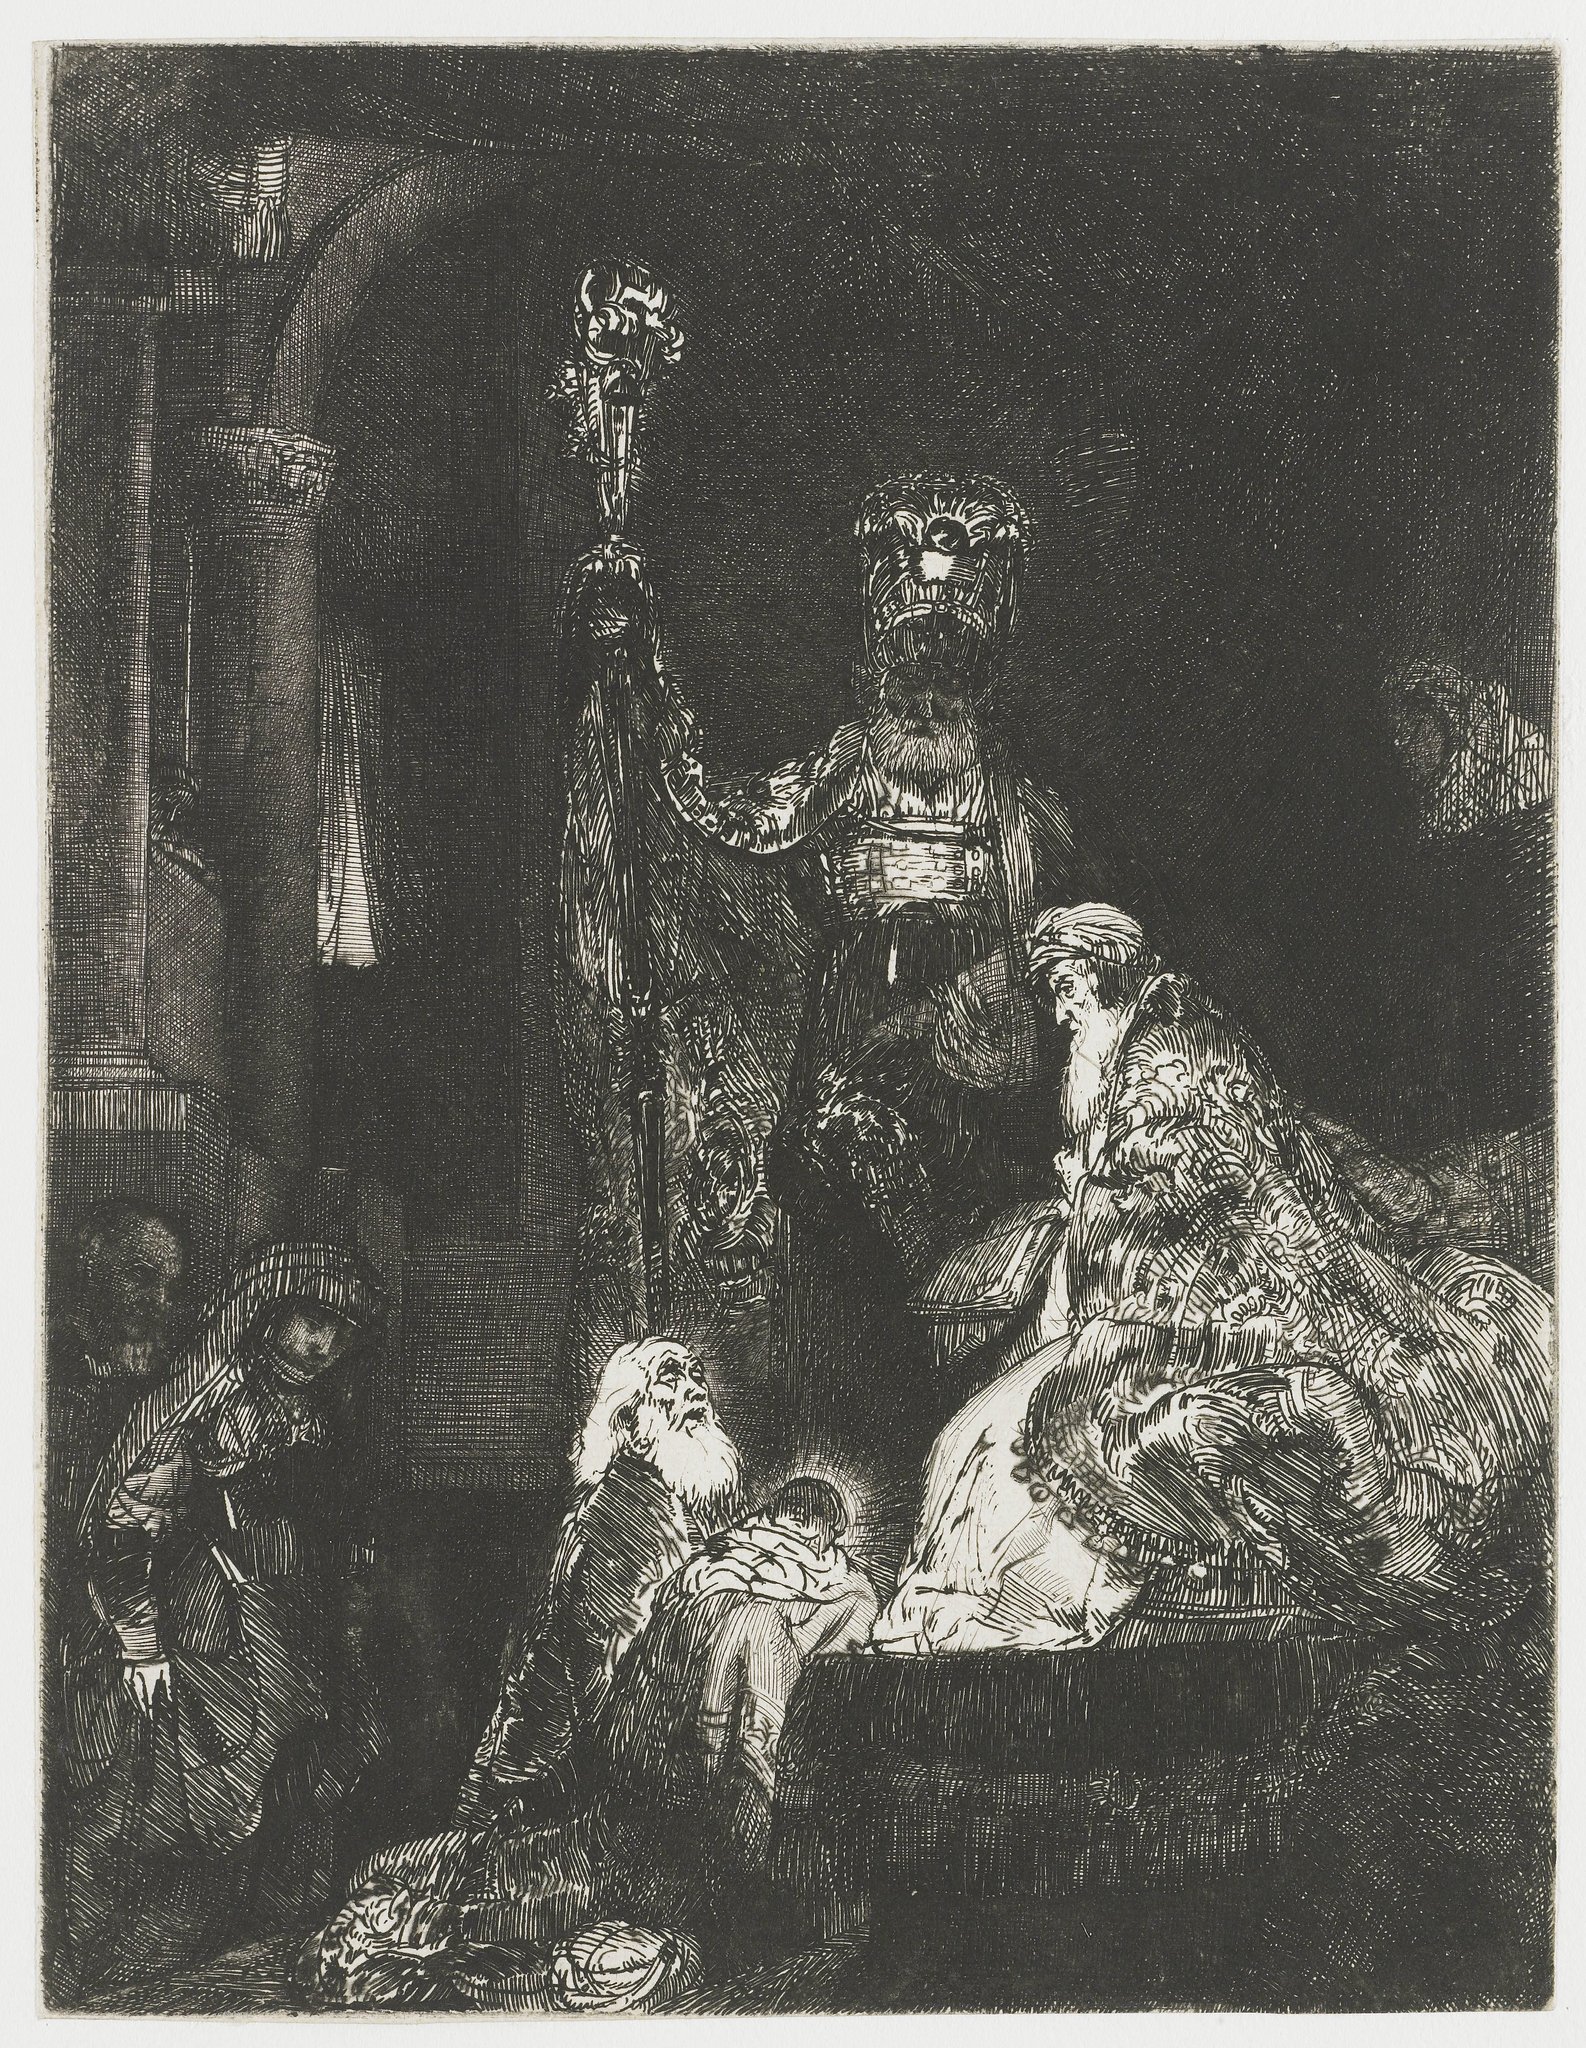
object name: print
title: The presentation in the temple in the dark manner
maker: rembrandt van rijn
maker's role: draughtsman, painter, print maker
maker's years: 1606-1669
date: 1654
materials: paper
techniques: drypoint, etching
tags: simeon, holding the christ-child, sings his canticle: 'nunc dimittis'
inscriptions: mark: Lugt 1606, mark: Lugt 2398, mark: Lugt 2434, mark: Lugt 2228